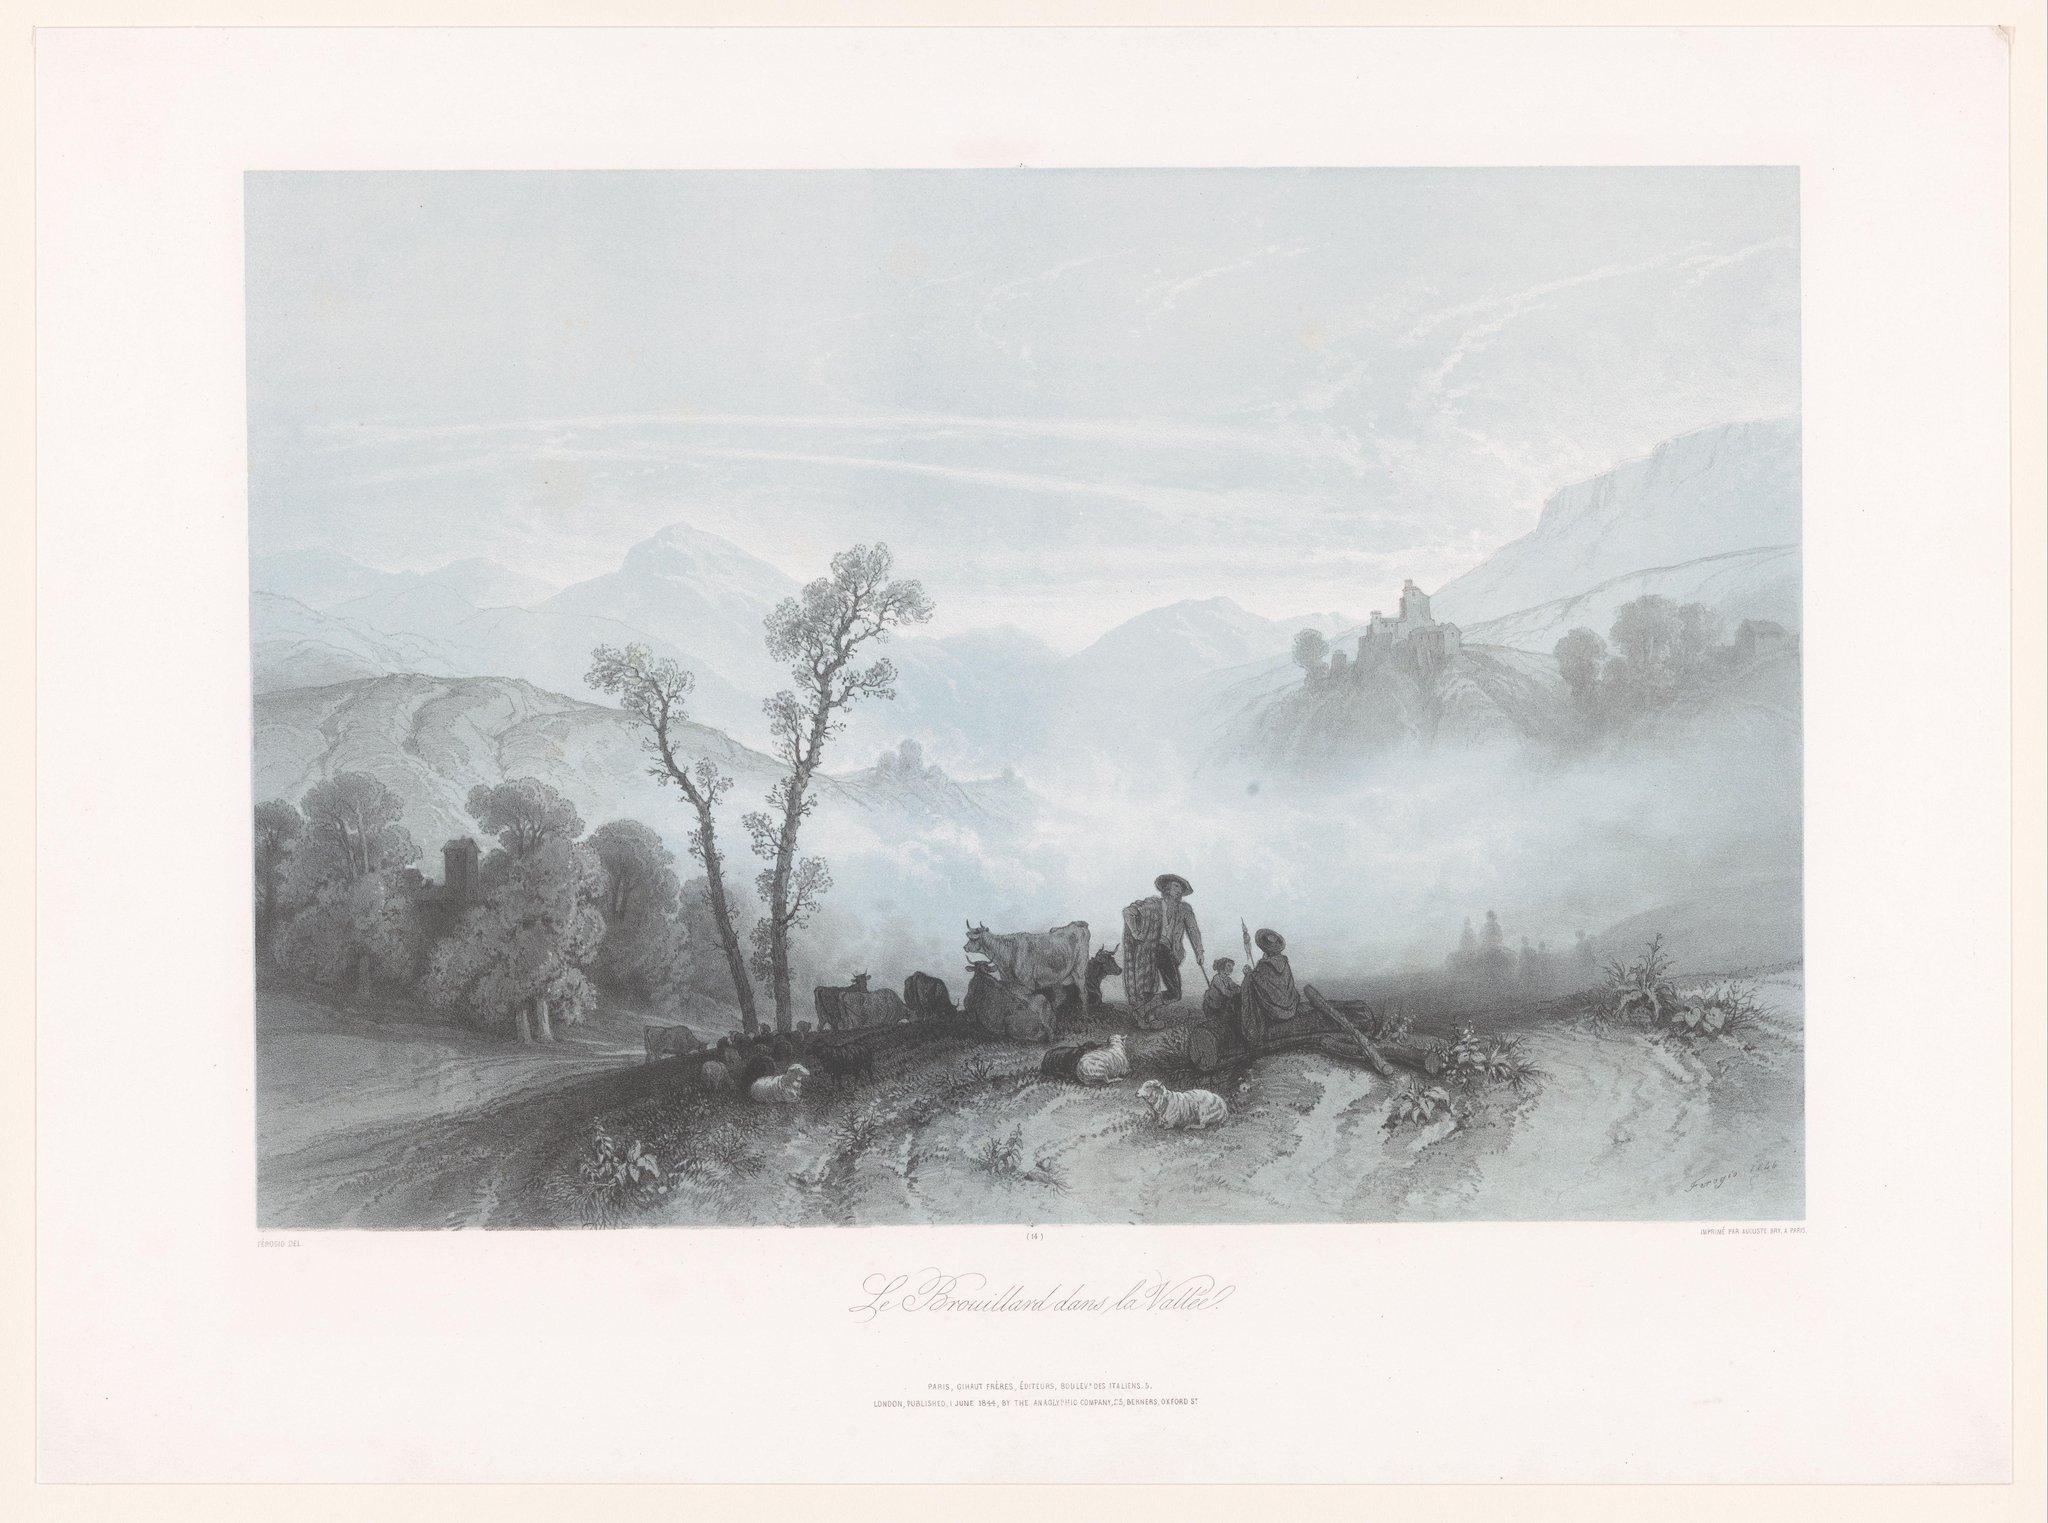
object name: print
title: Le Brouillard dans la Vallée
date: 1844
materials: paper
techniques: tone lithography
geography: paris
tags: castle, herding, herdsman, herdswoman, shepherd, shepherdess, cowherd, etc., mountains (+ landscape with figures, staffage), dale, valley (+ landscape with figures, staffage), mist, fog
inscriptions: collector's mark: Lugt 2228a